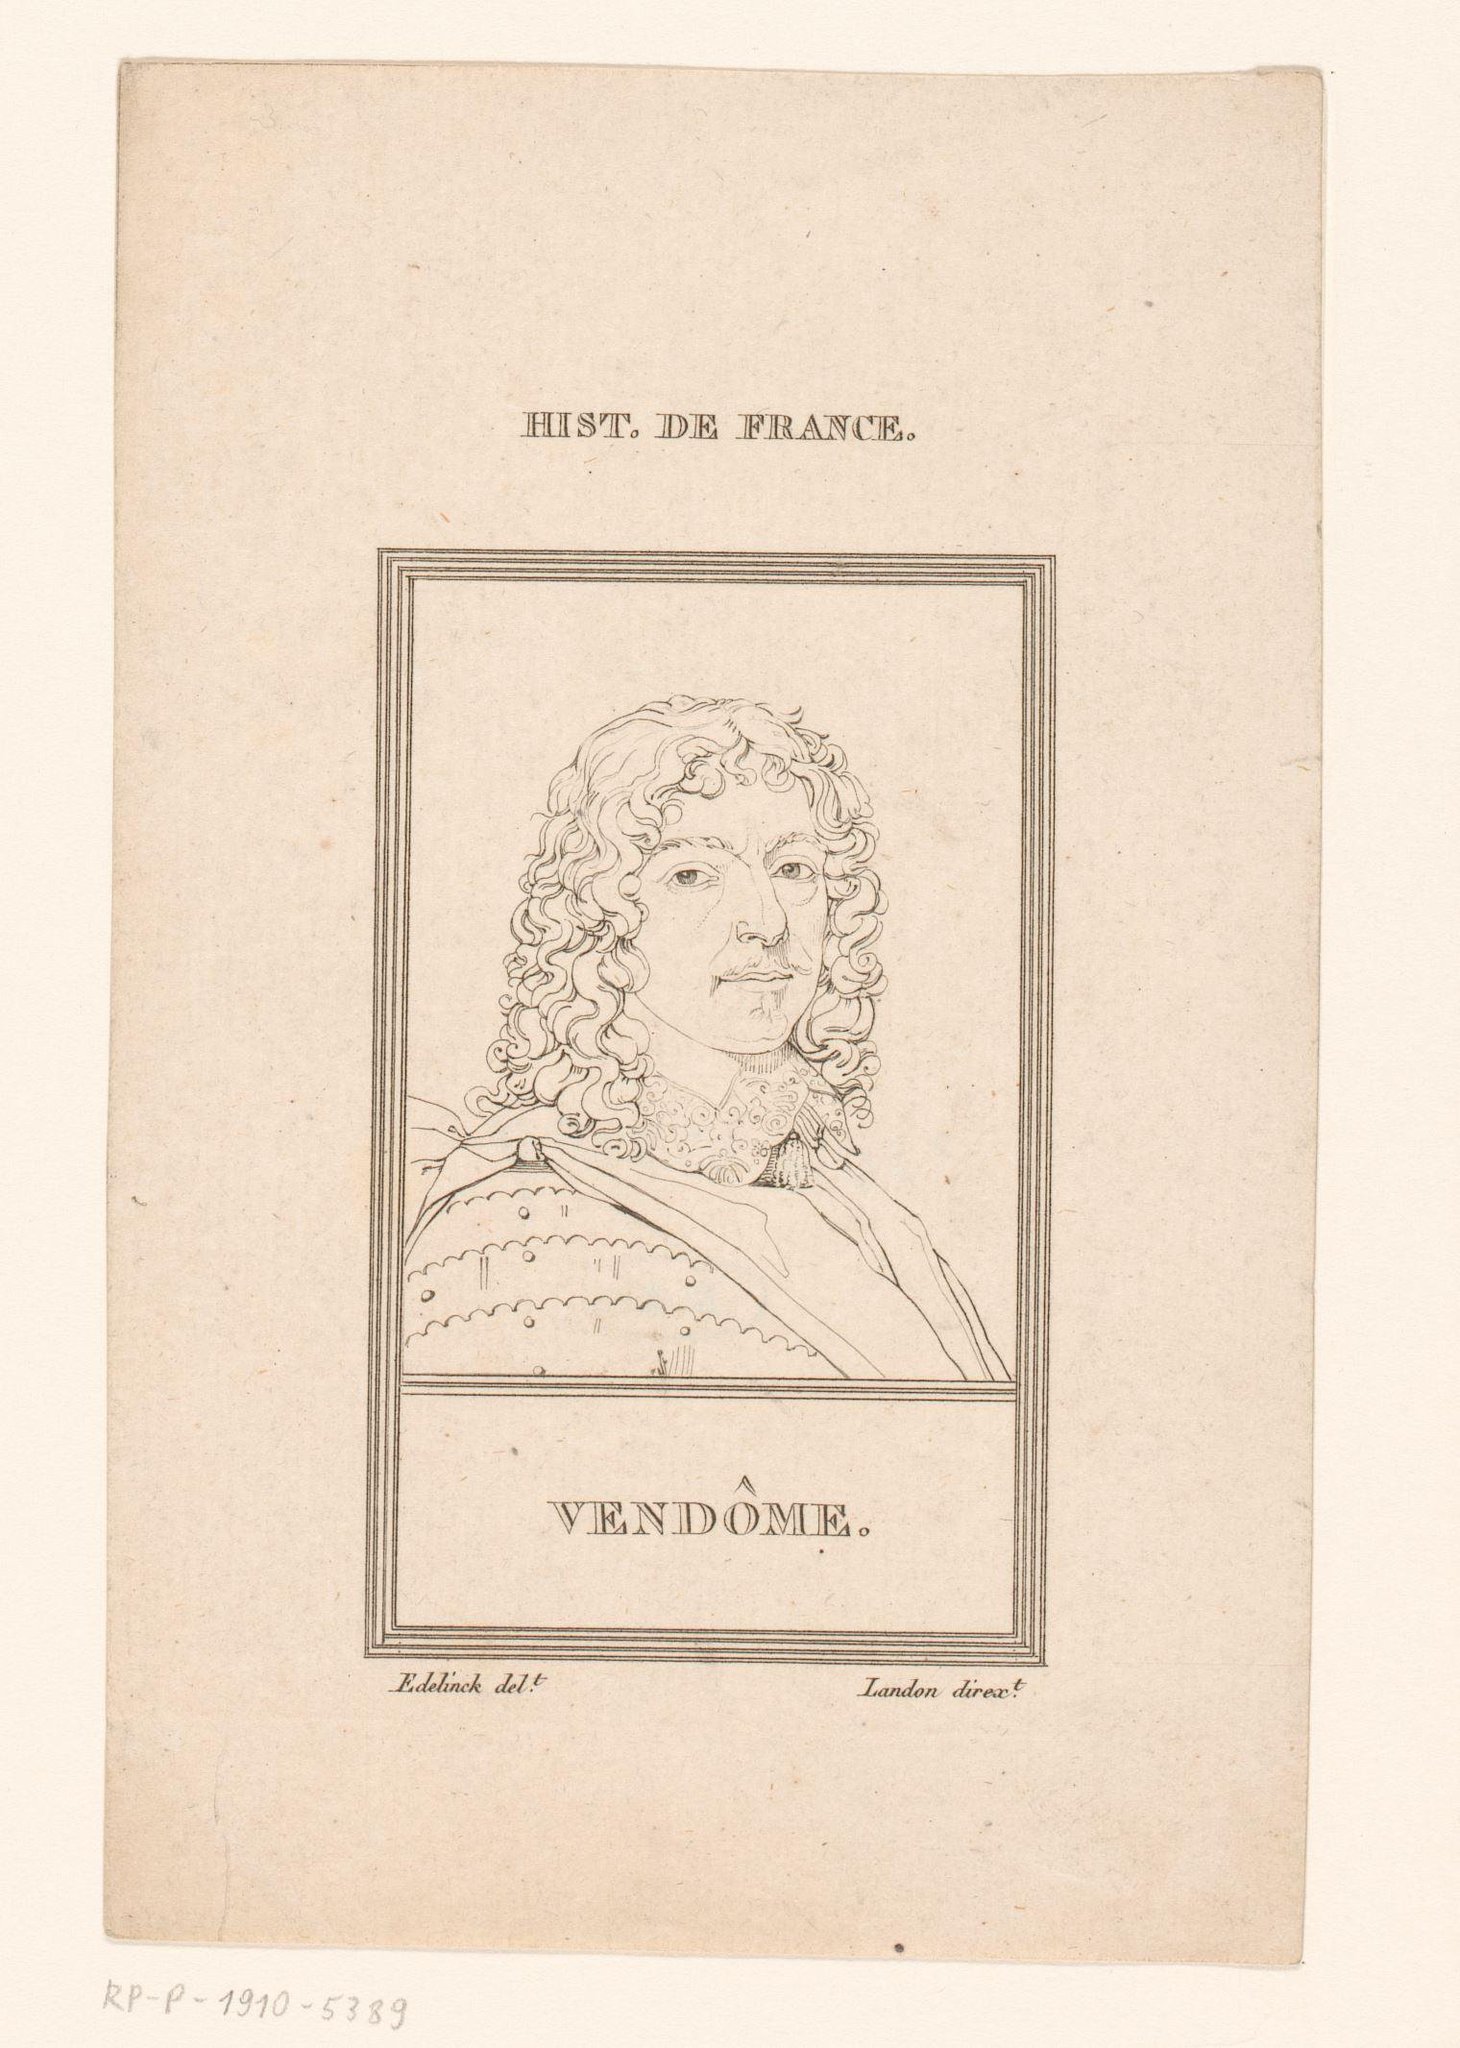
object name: print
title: Portret van Frans van Vendôme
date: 1805-1811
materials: paper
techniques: etching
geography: france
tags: historical persons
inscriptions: collector's mark: Lugt 2228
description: Prent uit: Landon, Charles Paul. Galerie historique des hommes les plus celebres de tous les nations. (...). Parijs: Musée et l'école des beaux-arts, 1805-1811.